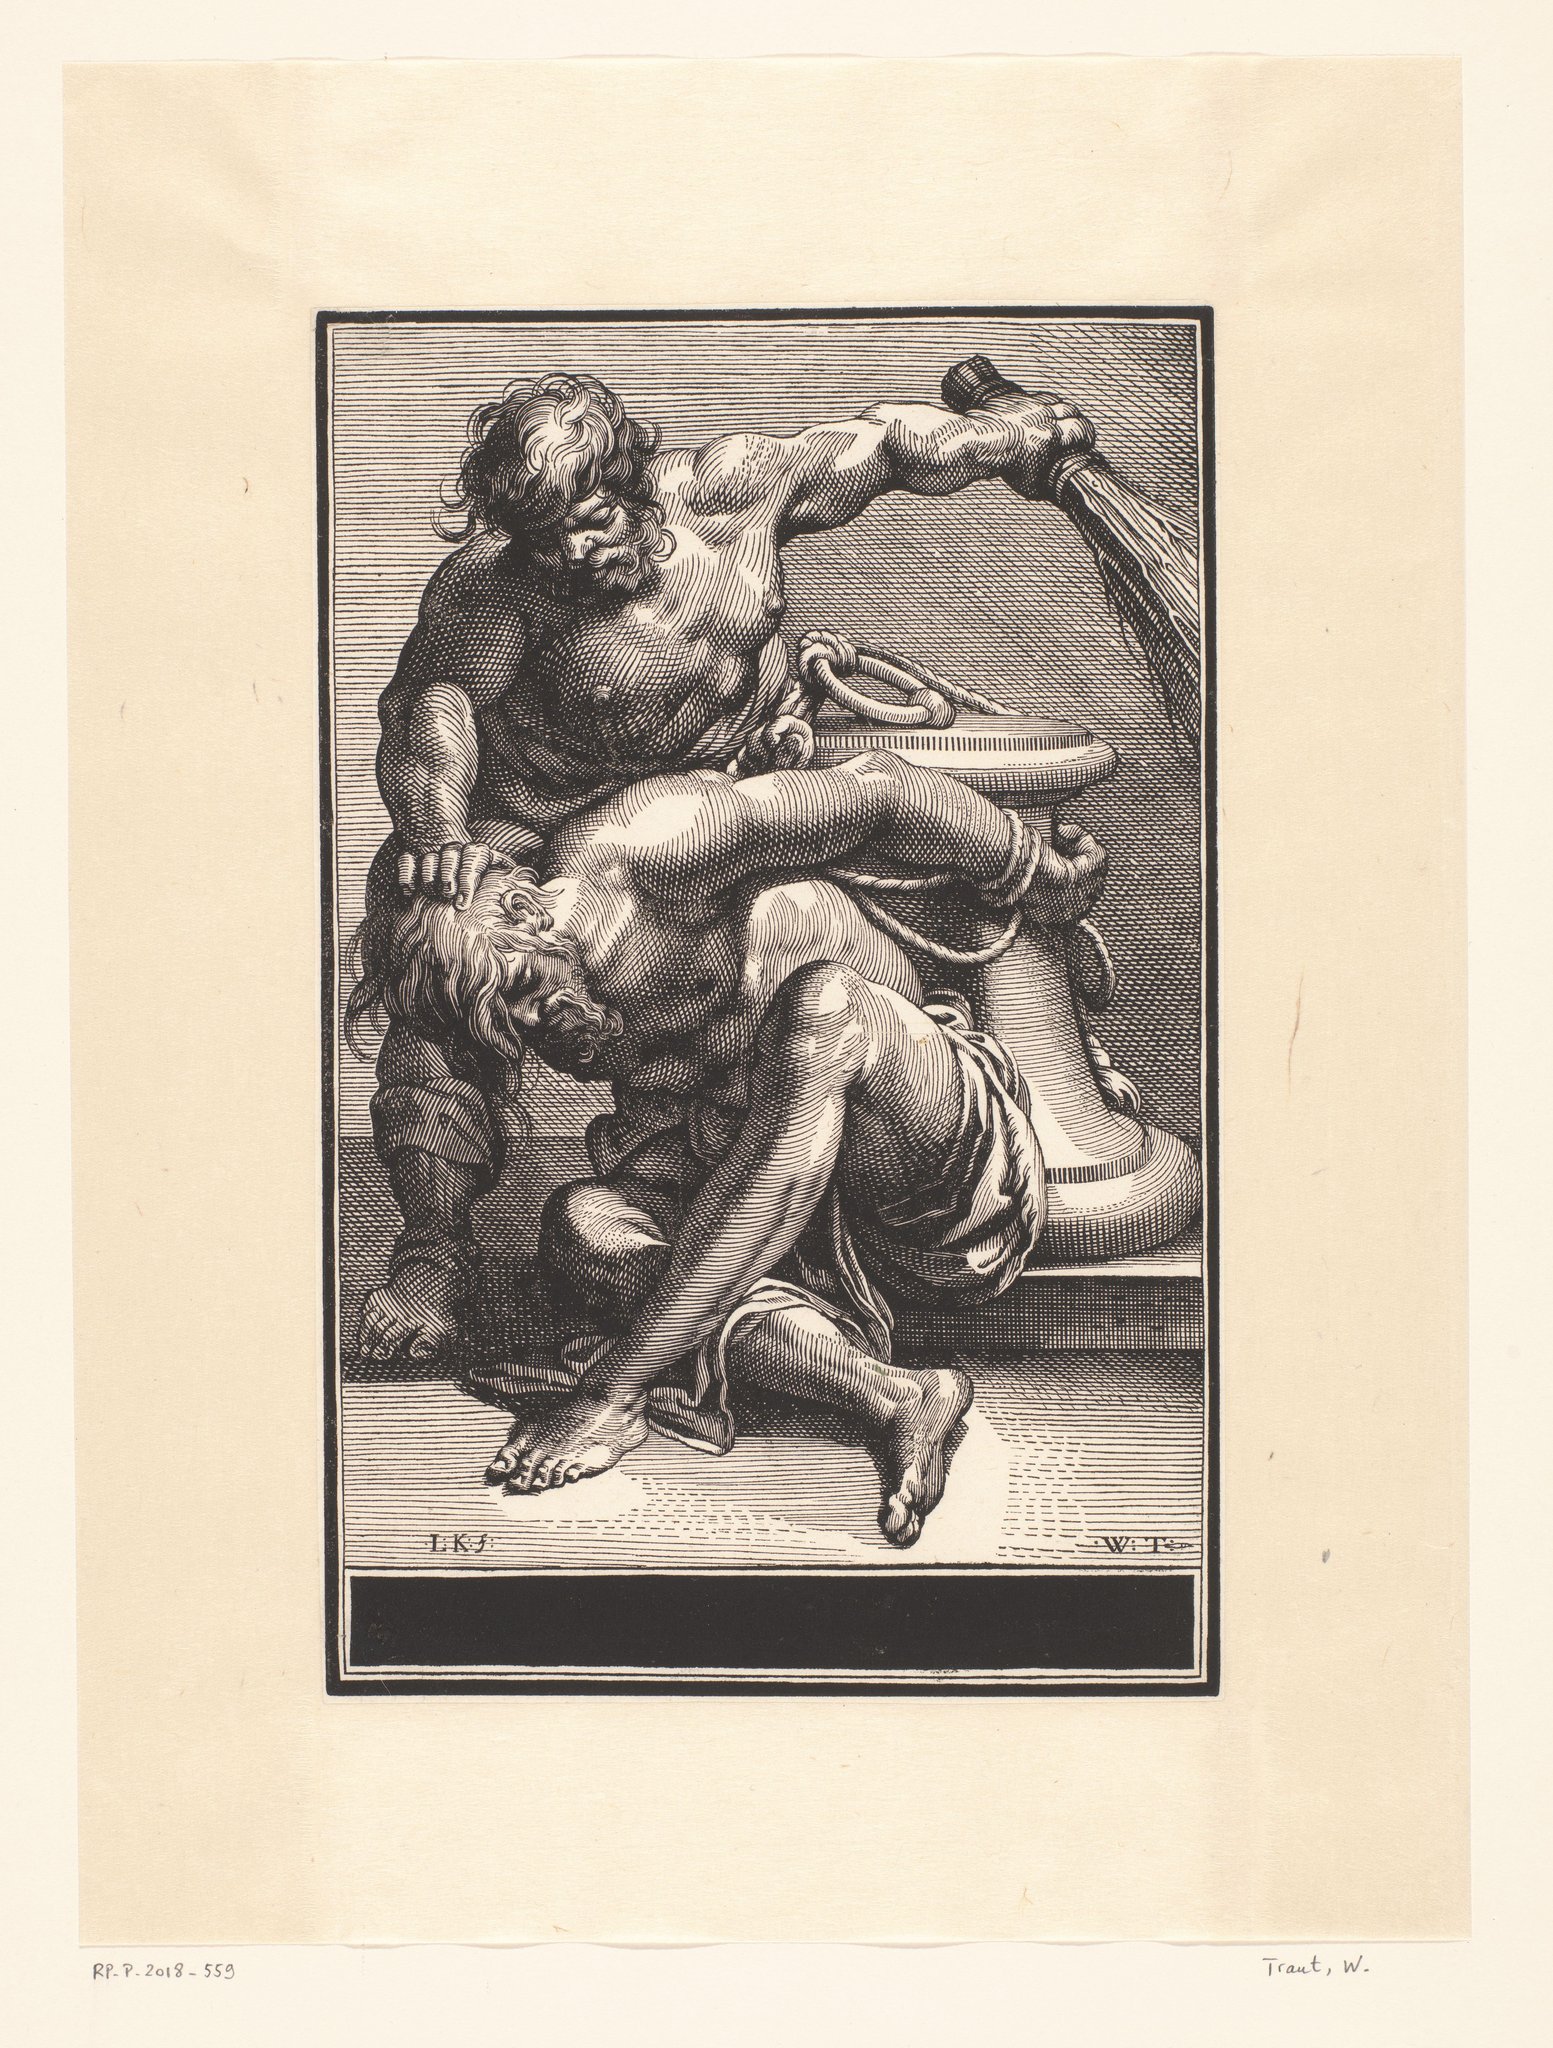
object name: print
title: De geseling van Christus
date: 1650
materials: paper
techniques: woodcut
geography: frankfurt am main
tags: flagellation by soldiers, christ usually tied to a column (matthew 27:26; mark 15:15; john 19:1)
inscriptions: collector's mark: Lugt 2760, collector's mark: Lugt 2228